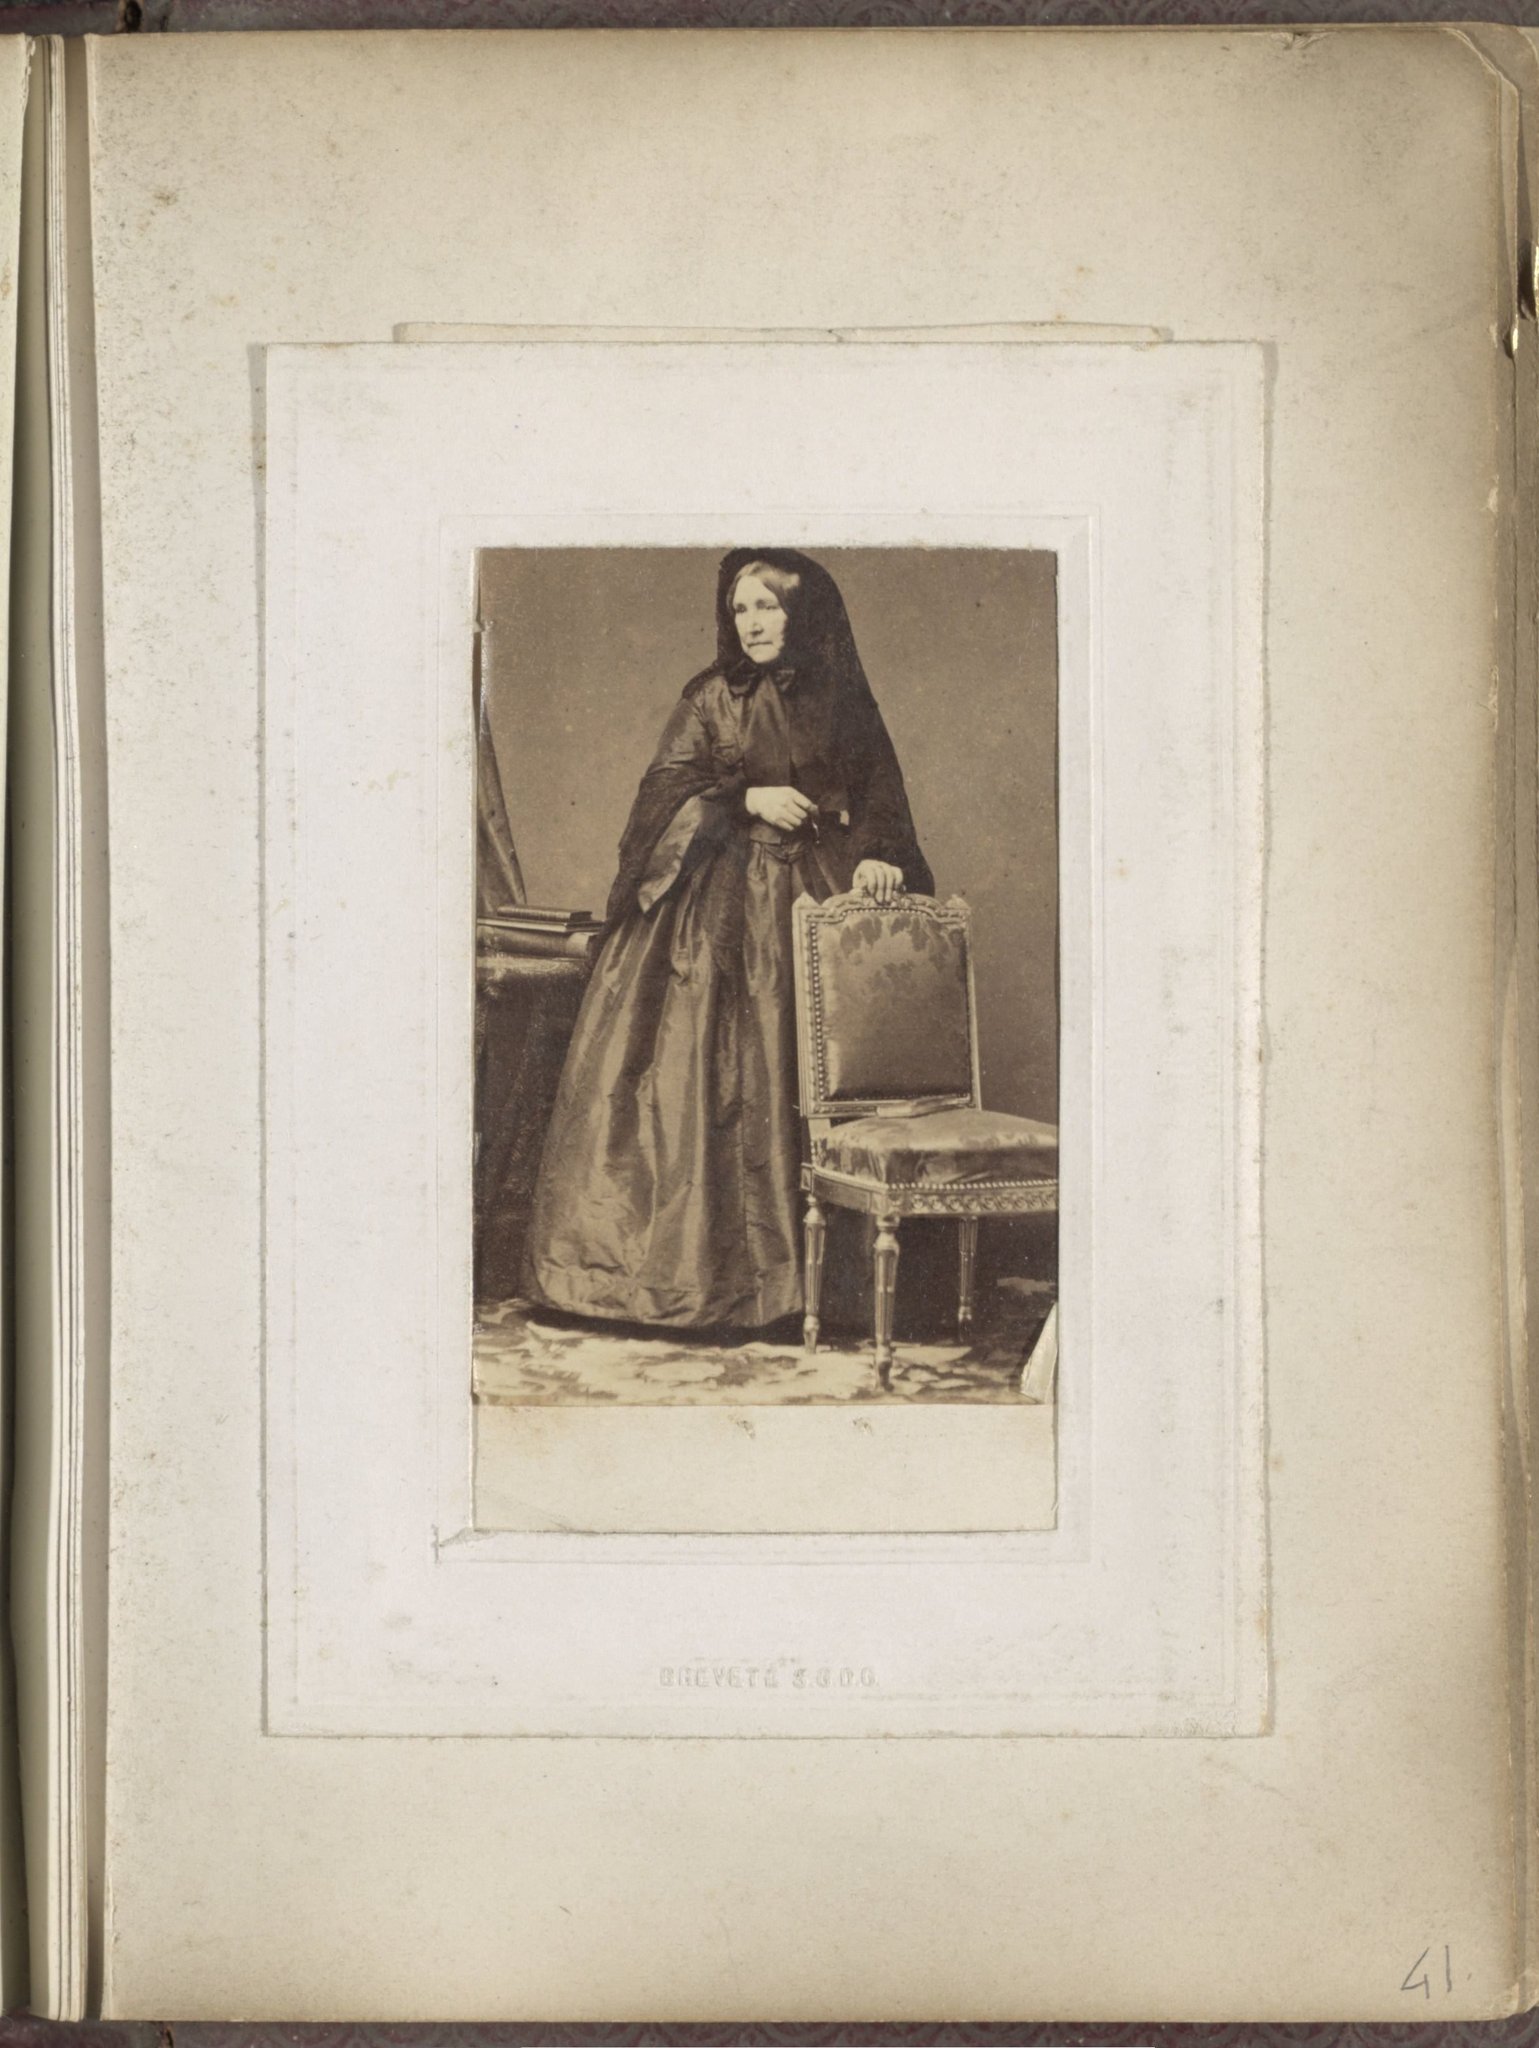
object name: photograph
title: Portret van een vrouw in een lange jurk met een sluier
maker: Anonymous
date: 1860-1865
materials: cardboard, paper, photographic support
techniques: albumen print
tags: studio requisites ~ photographer, historical persons, styles of hairdress - aa - ~ women, book, dress, gown, chair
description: Onderdeel van Fotoalbum met 48 cartes-de-visite aangeboden aan maarschalk graaf De Castellane.